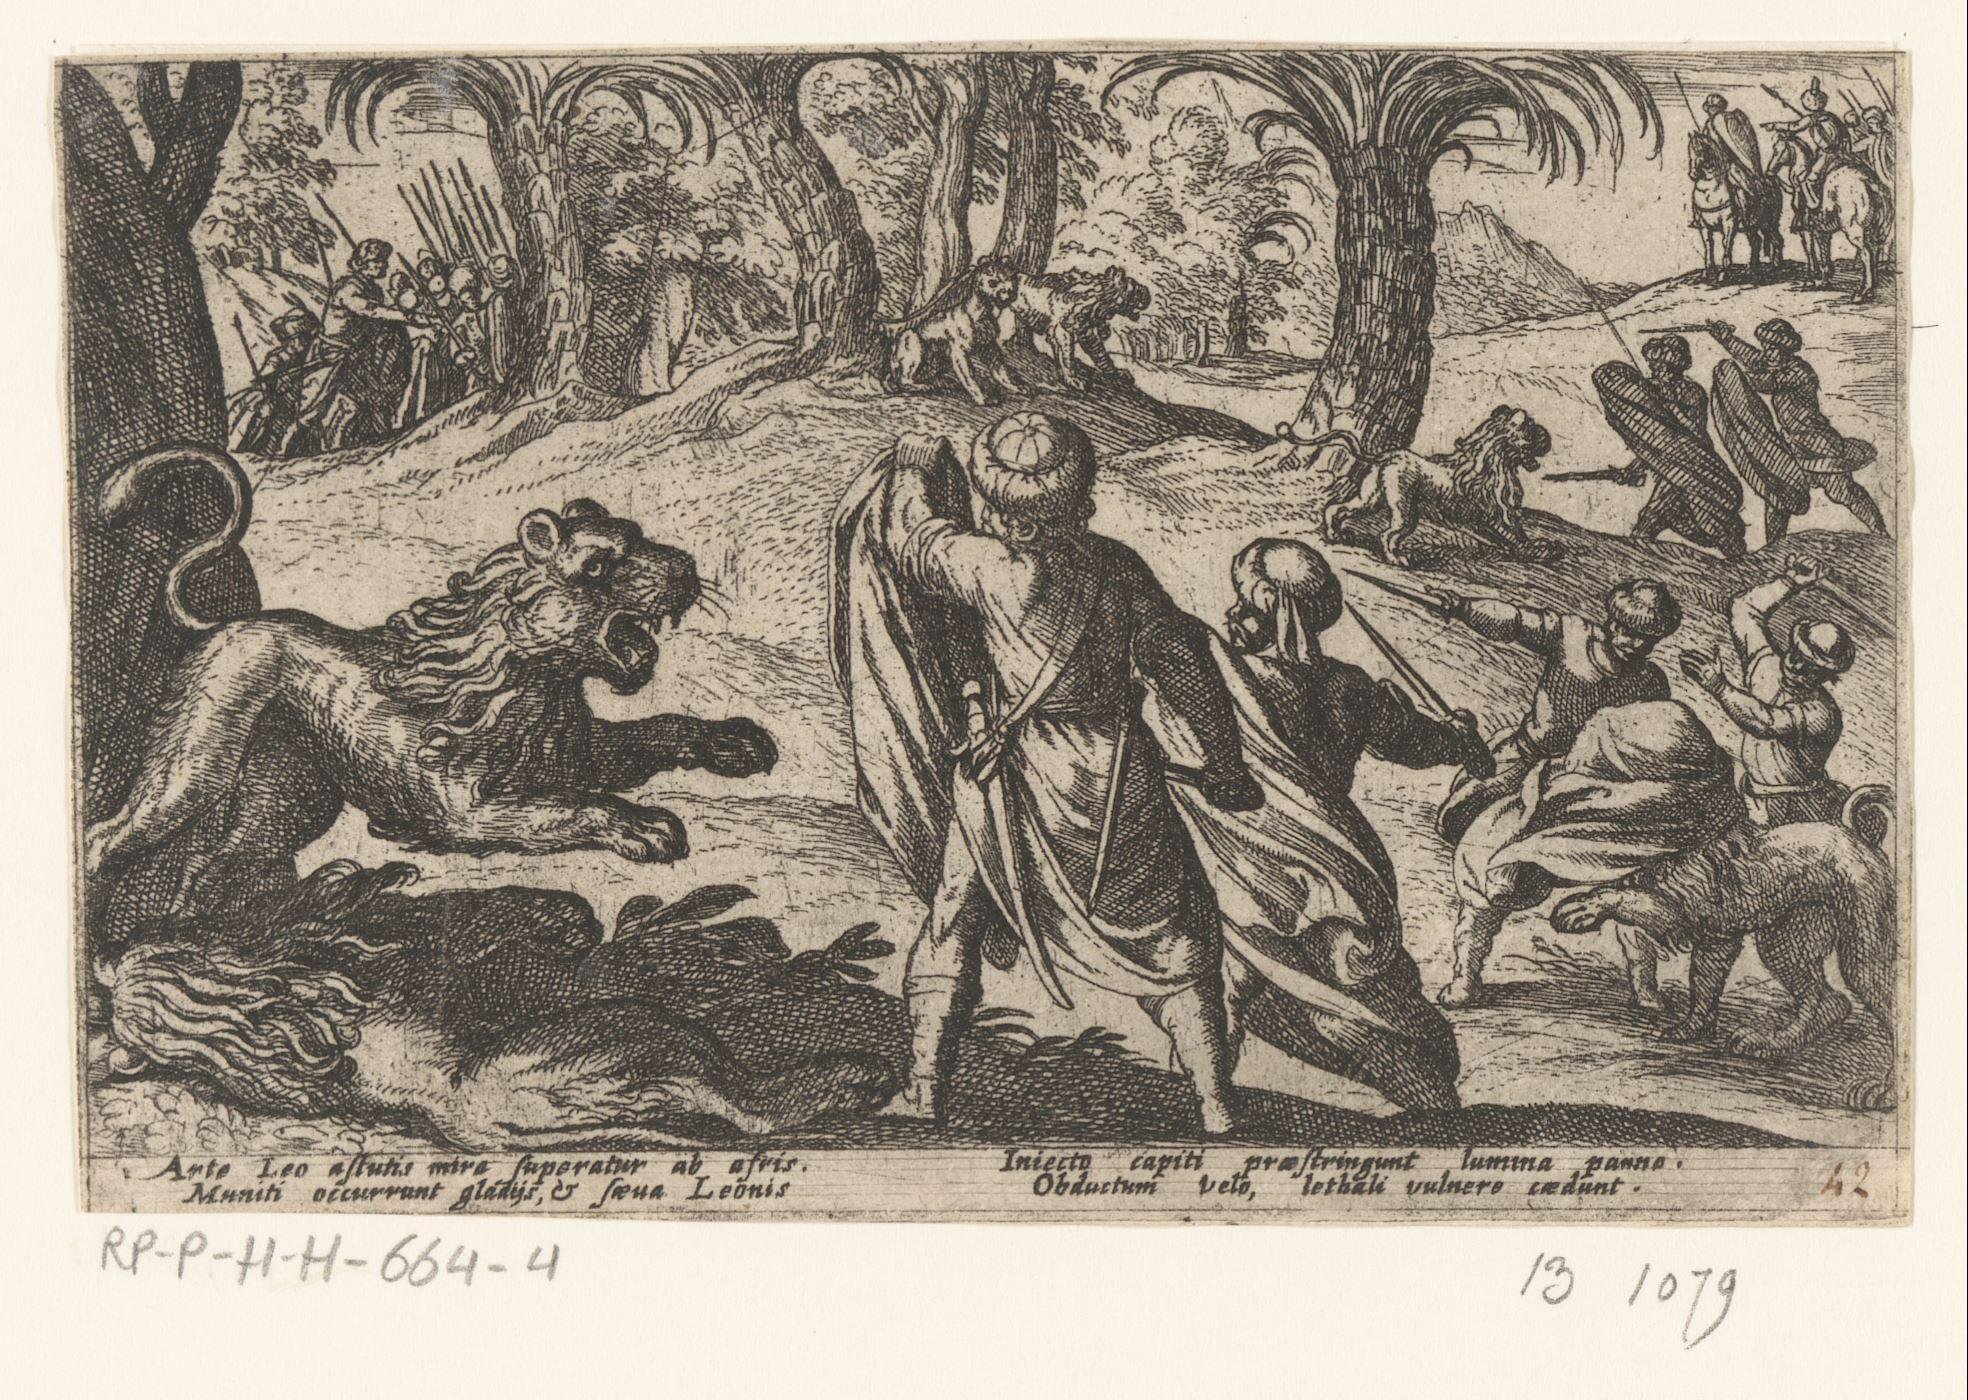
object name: print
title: Jacht op leeuwen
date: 1605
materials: paper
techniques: etching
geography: italy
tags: lion hunt, hunter, hunters hunting (n.b.: in 1988-1990 this notation denoted the concept of 43c11421 'hunters resting during the hunt')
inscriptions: collector's mark: ‘Hinloopen’, number: ‘42’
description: Landschap met jagers met dolken en doeken jagend op leeuwen. De jagers proberen een doek over de kop van de leeuw te gooien, om de leeuw vervolgens met de dolk dood te steken. Tekst in het Latijn in ondermarge.